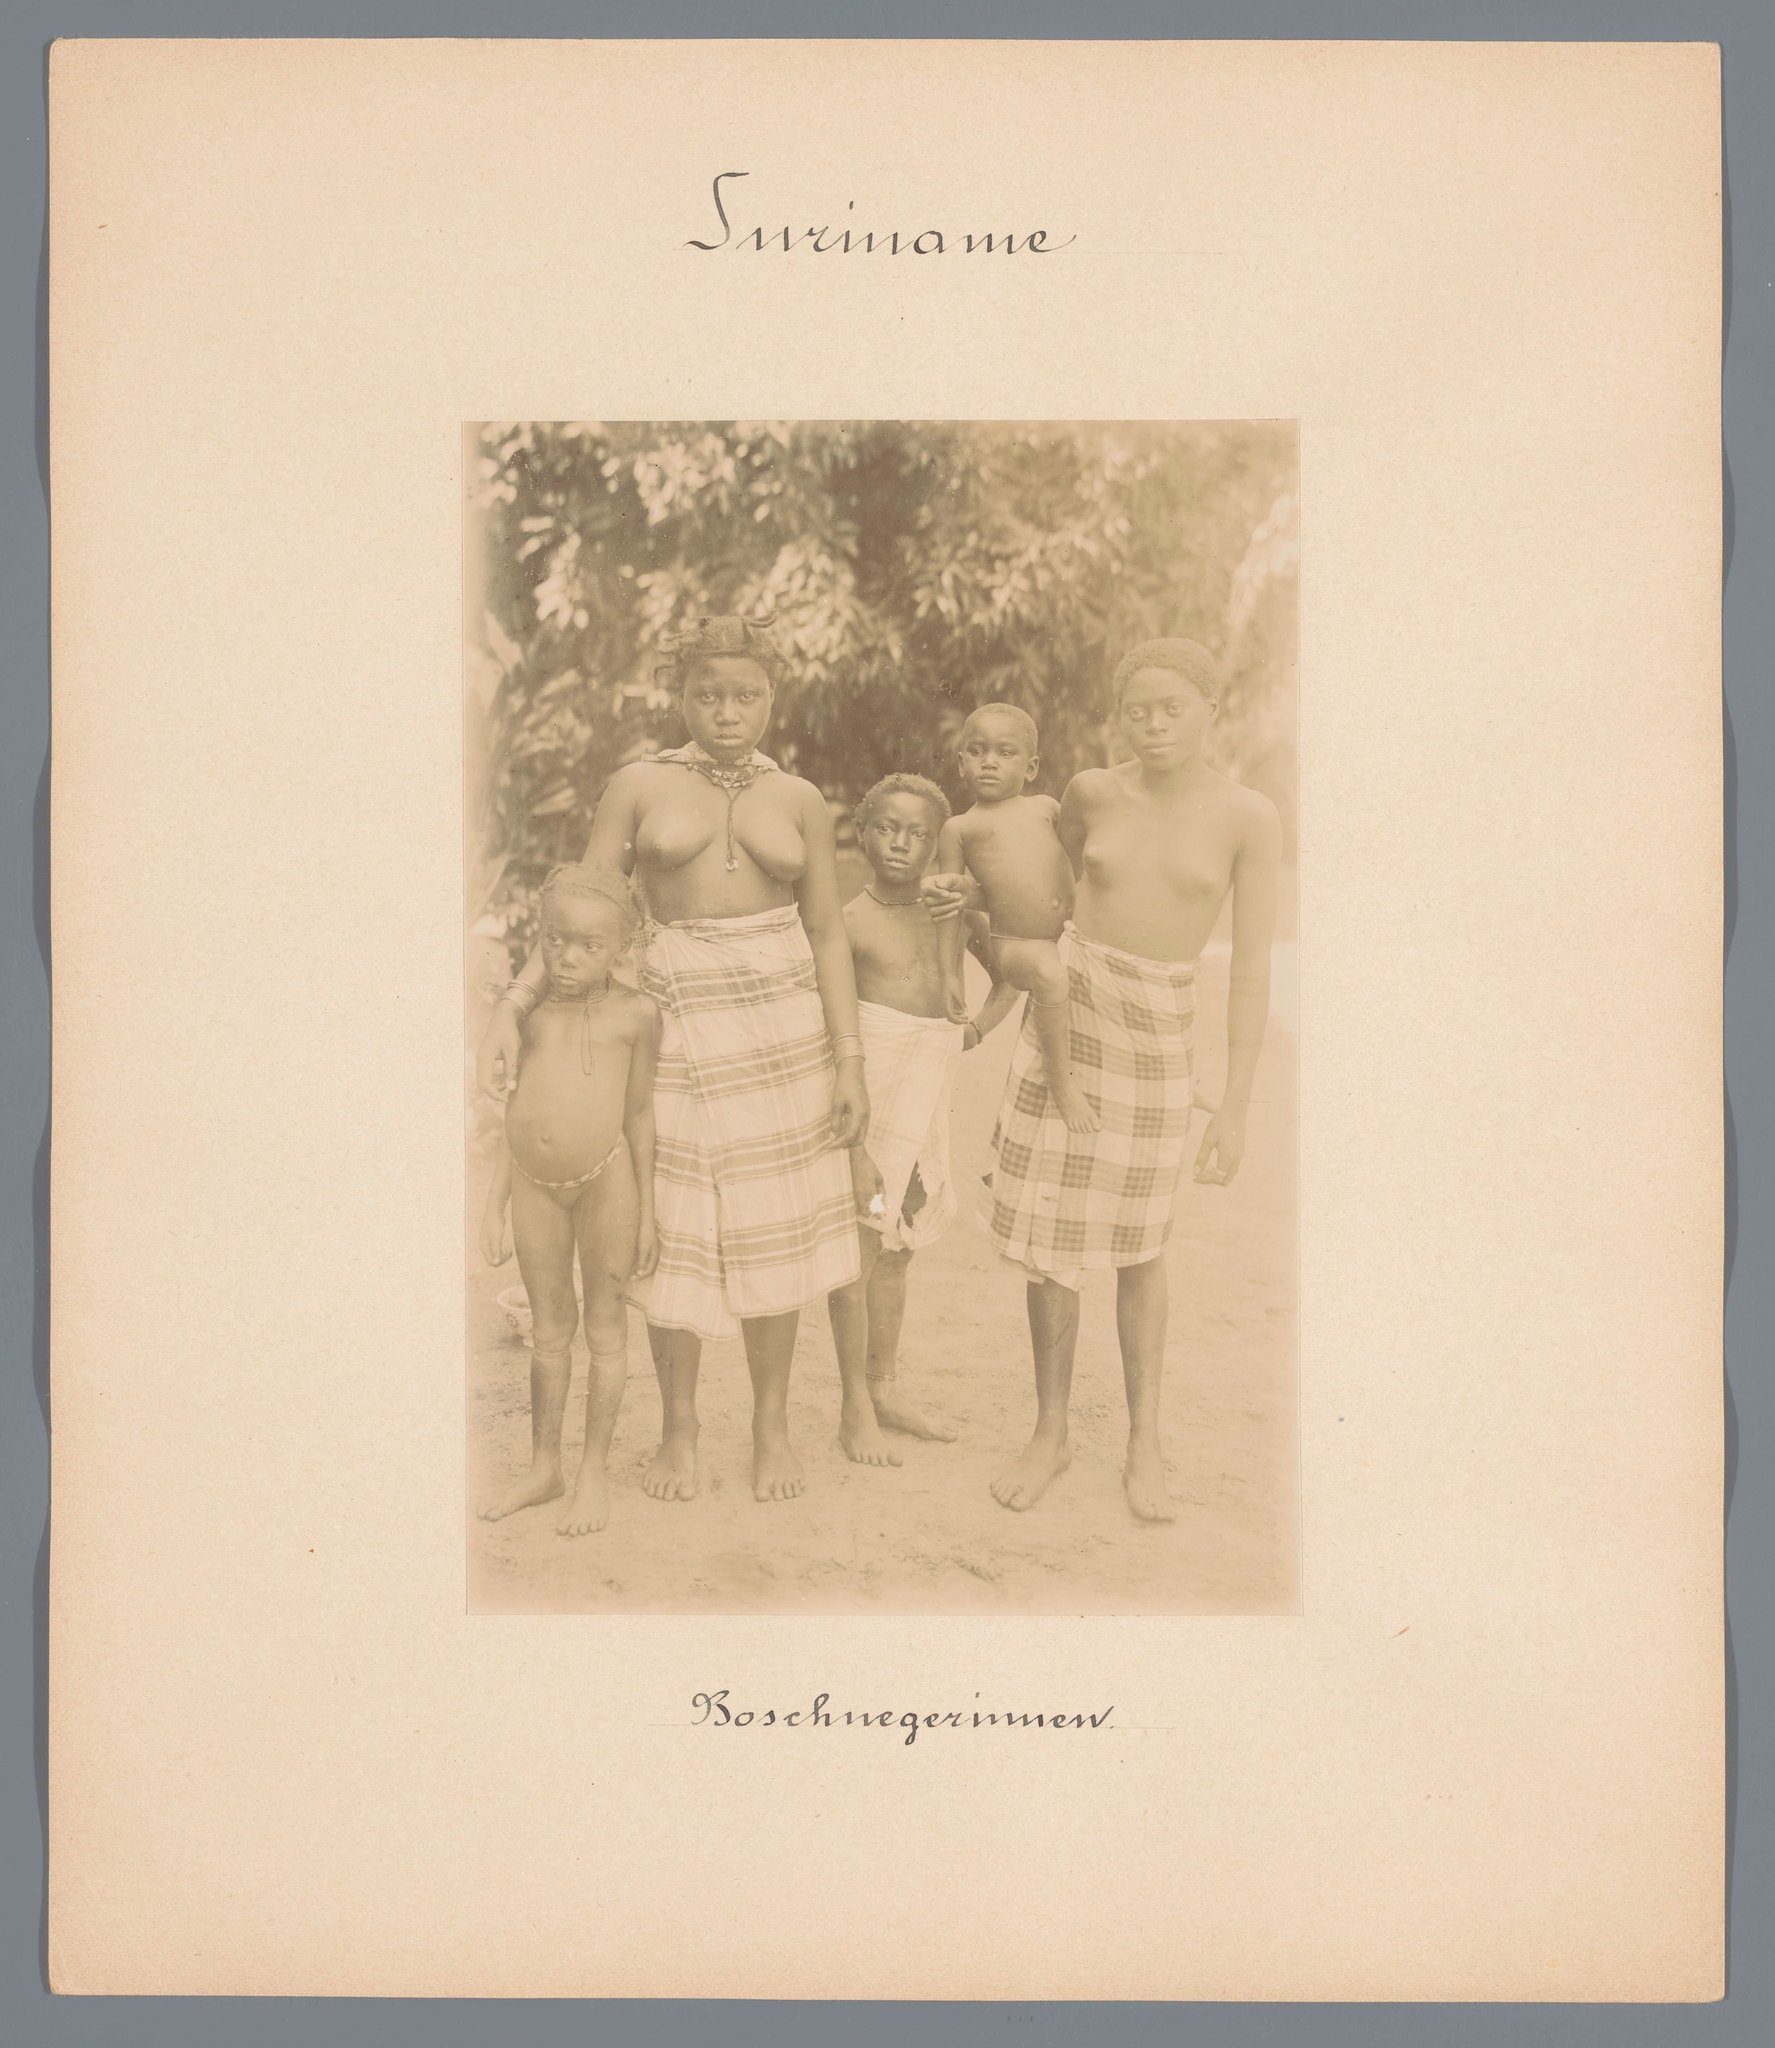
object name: photograph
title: Marronvrouwen en -meisjes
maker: eugen klein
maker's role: fotograaf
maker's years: 1869-1927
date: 1900-1905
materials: cardboard, photographic support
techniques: gelatin silver print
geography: paramaribo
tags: suriname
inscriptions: inscription: ‘Suriname / Boschnegerinnen’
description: Portret van enkele jonge Marronvrouwen en -meisjes. Onderdeel van een groep van 44 foto's van Paramaribo, Suriname en Curaçao, ca. 1900-1905, opgeplakt op kartons en voorzien van opschriften.